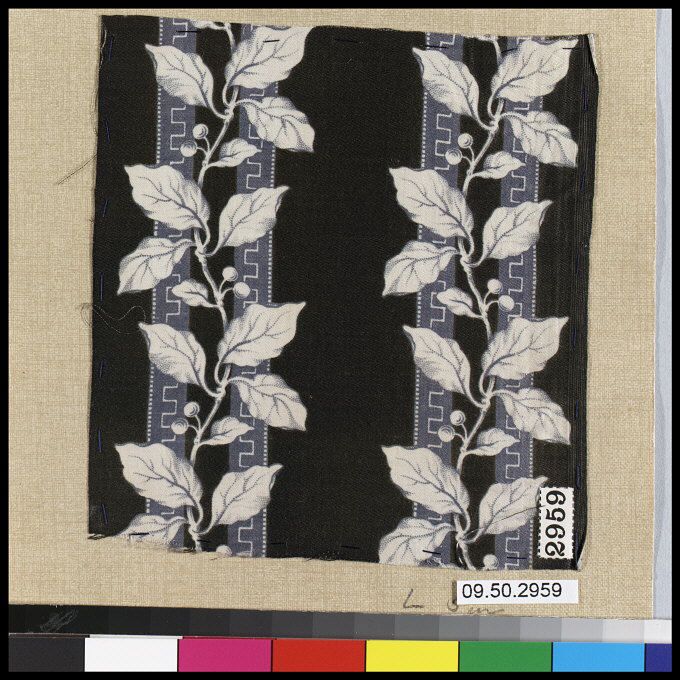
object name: piece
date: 1801-1900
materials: cotton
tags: leaves